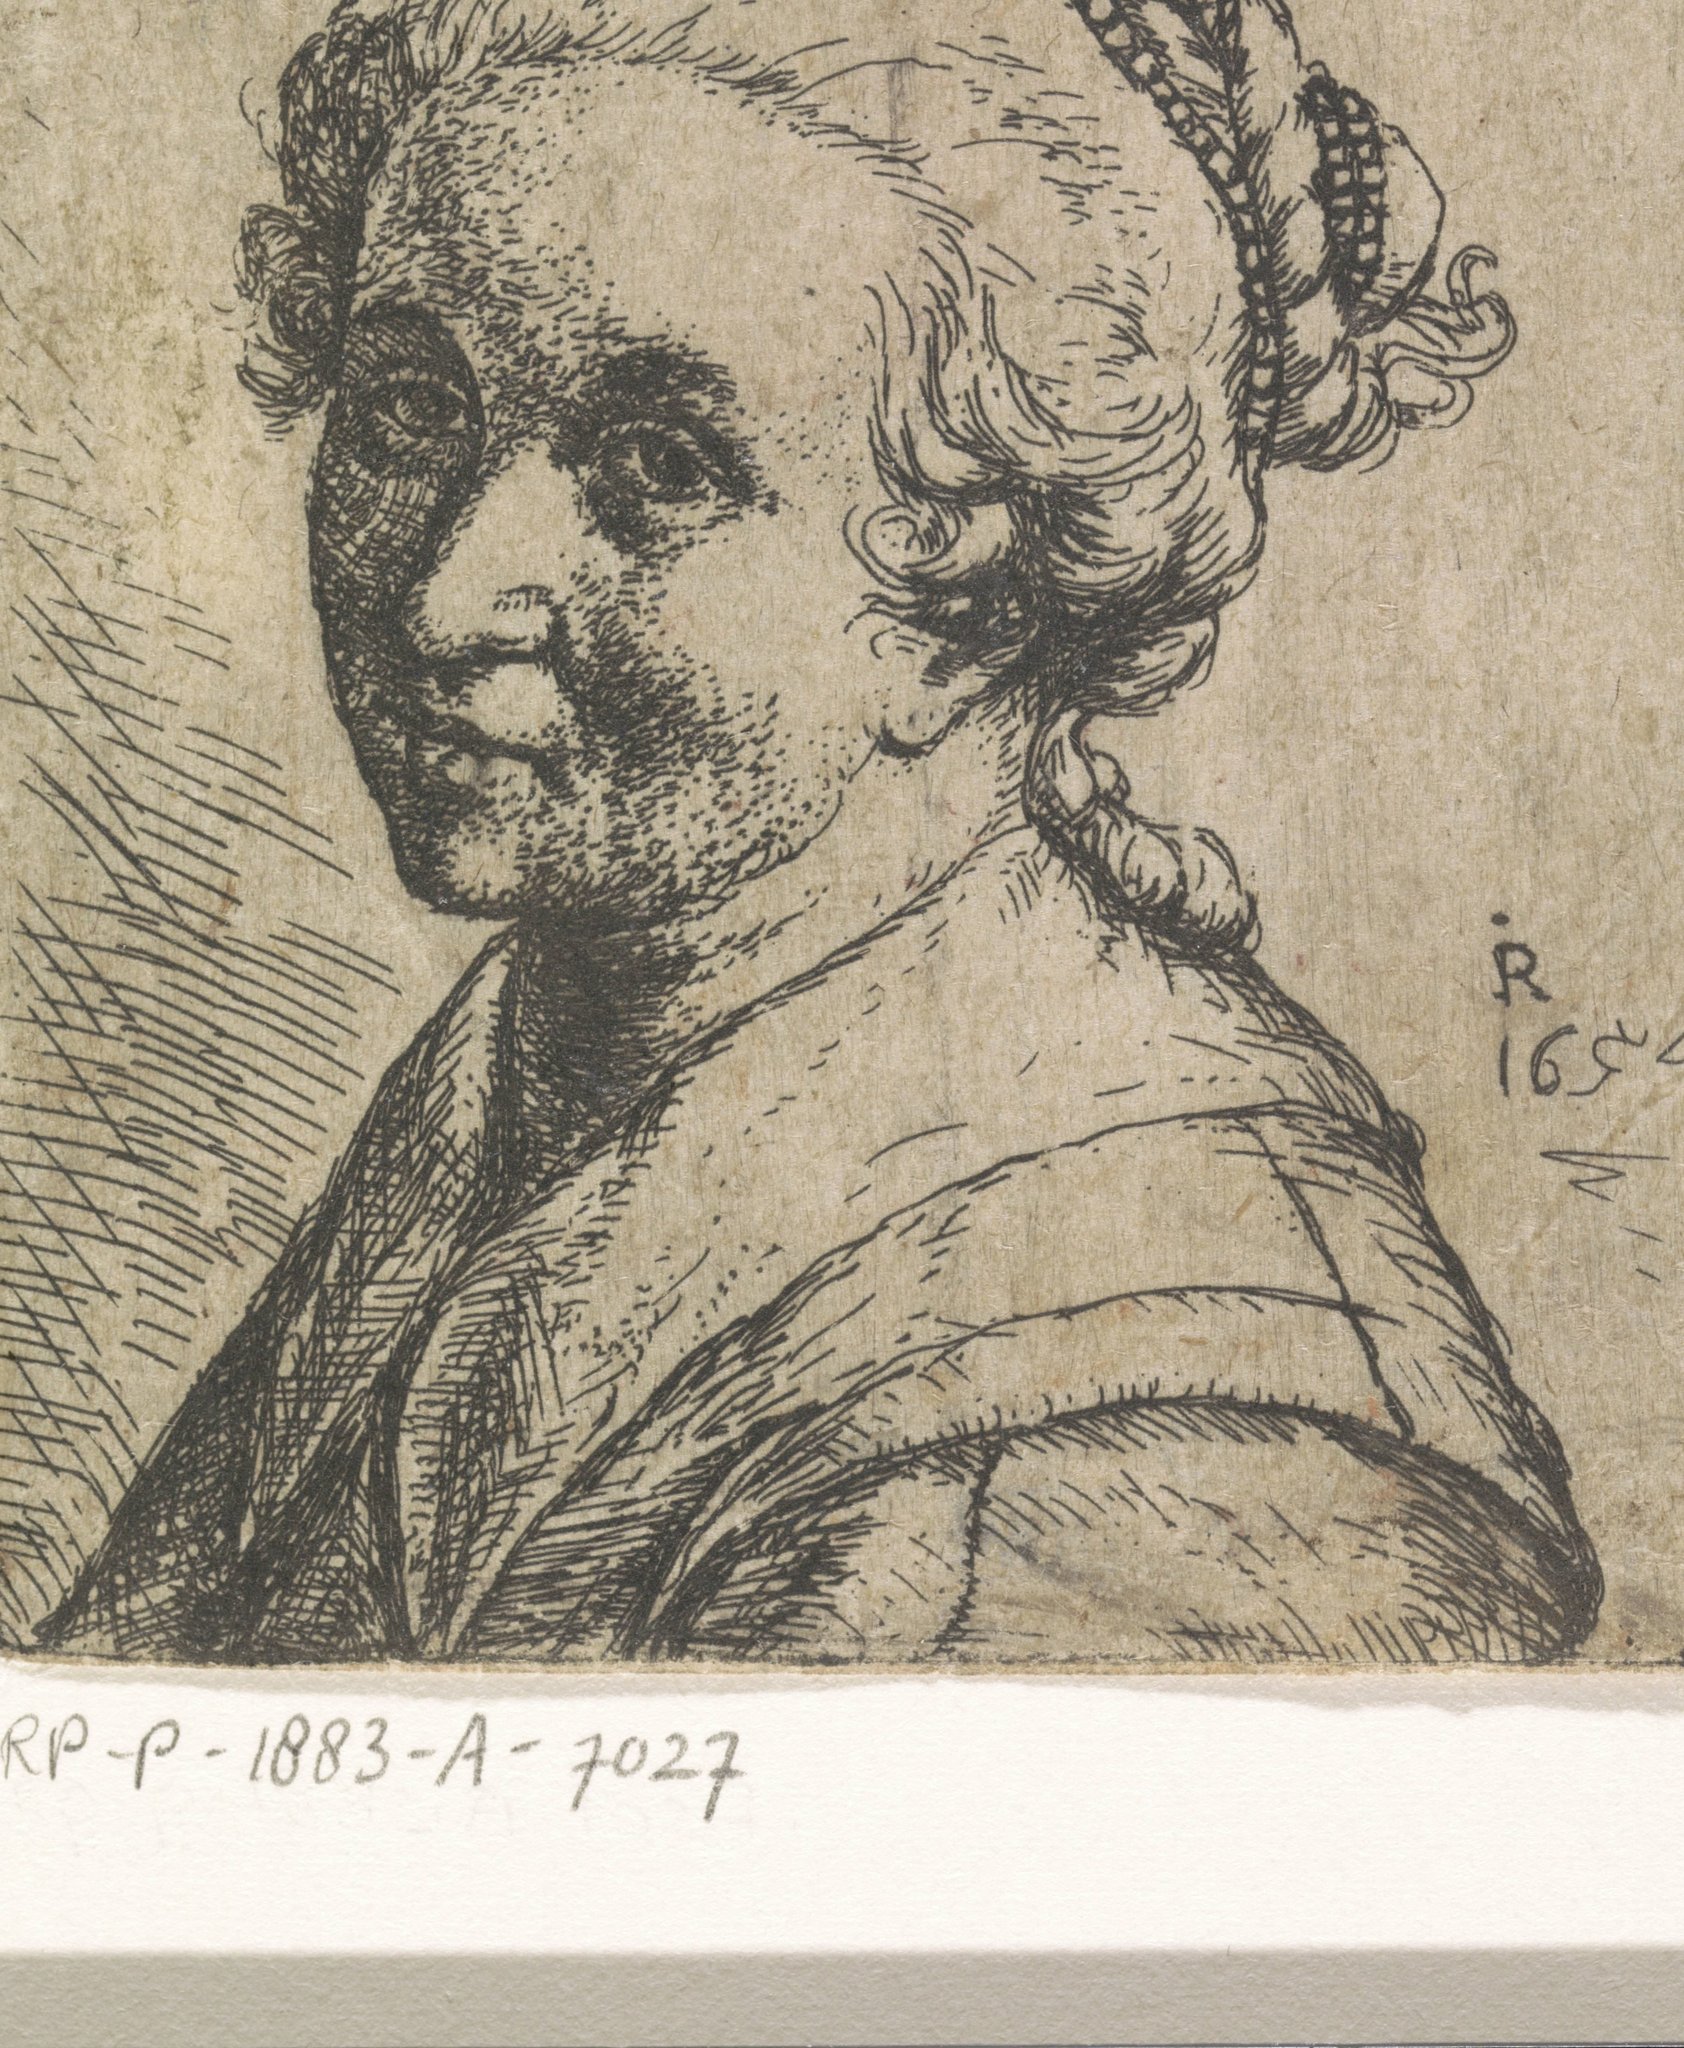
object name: print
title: Buste van een vrouw met een parelsnoer in het haar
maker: monogrammist r (graveur)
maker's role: print maker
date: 1654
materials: paper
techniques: etching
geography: amsterdam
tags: pearl; pearl necklace (+ variant), chest, bust - aa - female human figure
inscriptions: collector's mark: Lugt 2227